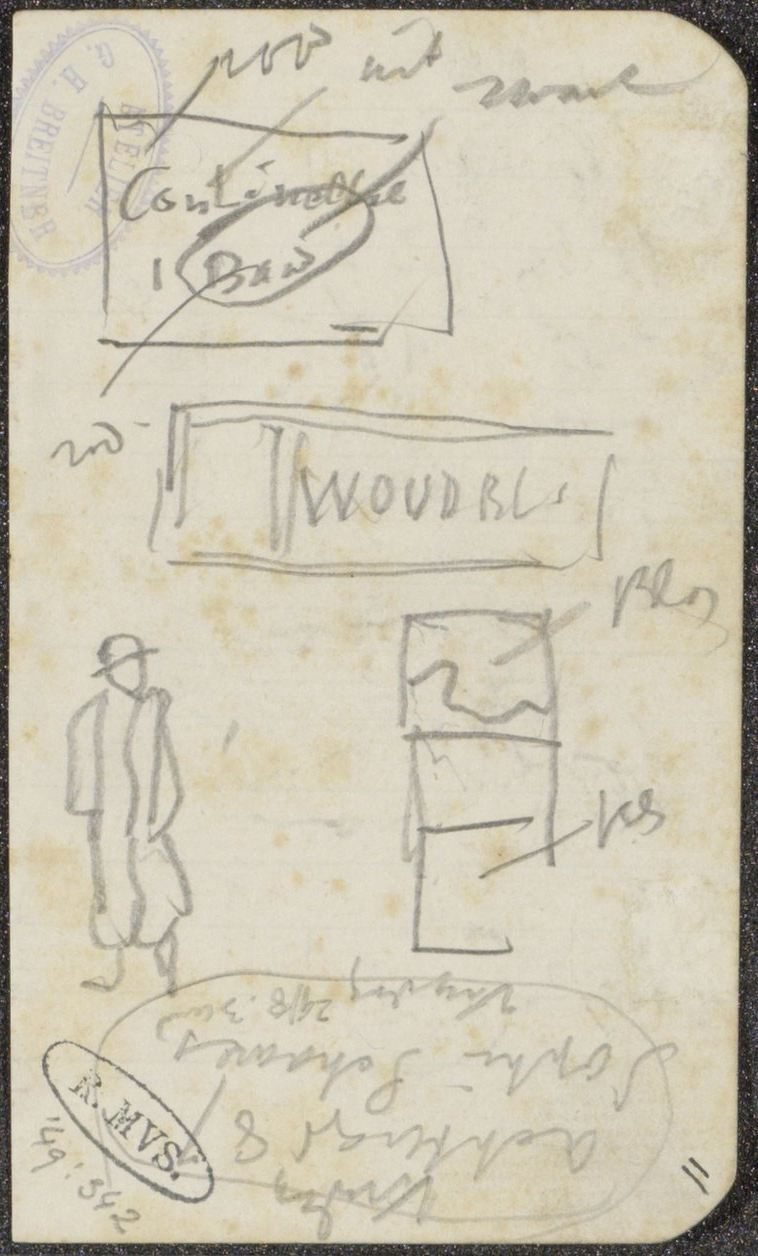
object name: drawing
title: Figuur en compositiestudies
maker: george hendrik breitner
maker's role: draughtsman, painter, print maker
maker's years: 1857-1923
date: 1890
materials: pencil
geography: amsterdam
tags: standing figure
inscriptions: annotation: ‘[...]/ Achtergr 8/ Sophie Schaars/ Vrijdag 29/8 3 uur’